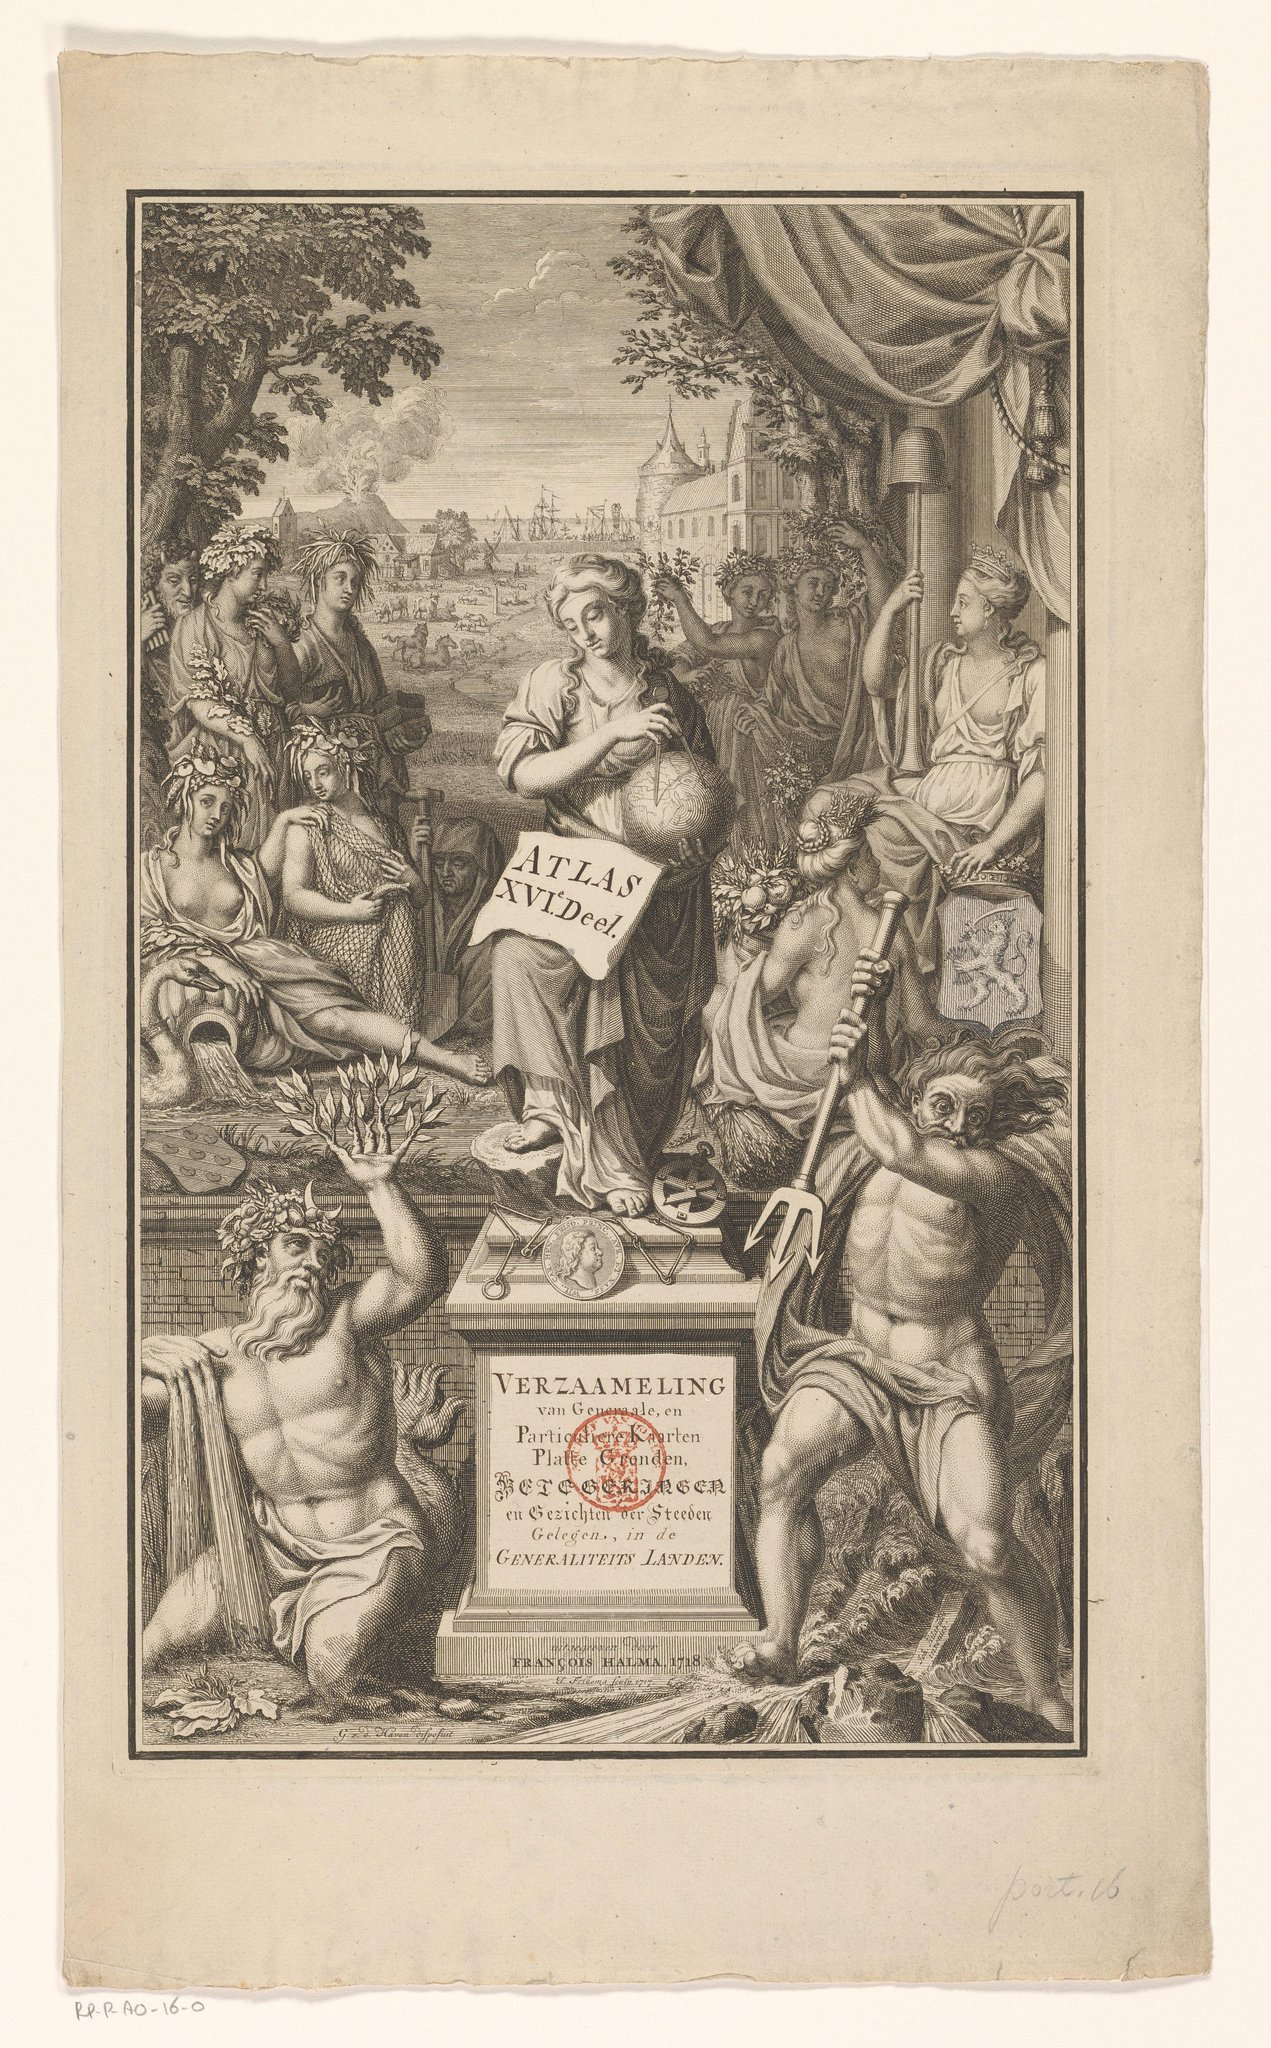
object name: titelprent, frontispice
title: Titelprent voor portefeuille 16 van de Atlas Ottens (Generaliteitslanden)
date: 1717-1718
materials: ink, paper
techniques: engraving, etching, pen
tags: commercial fishery, (story of) ceres (demeter), peat-cutting, 'astronomia', 'cosmografia'; 'cosmografia' (ripa), personifications of countries, nations, states, districts, etc., river-gods, 'corografia', 'geografia', 'hidrografia' (ripa), agriculture, fruitfulness, productiveness, fertility, fecundity; 'fecondità' (ripa), (story of) flora, coat of arms (as symbol of the state, etc.) (+ province; provincial), neptune as lord of the sea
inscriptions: collector's mark: Lugt 19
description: Deze prent is hier gebruikt als titelprent van een deel van een ongebonden atlas; een verzameling cartografische en topografische prenten en tekeningen. Oorspronkelijk was de prent echter bedoeld als titelpagina voor een gebonden atlas met kaarten van Friesland, waardoor een deel van de hier volgende beschrijving betrekking heeft op die context. Op het voetstuk in het midden staat de personificatie van de cartografie, met in haar hand een aardbol die ze met een passer meet. Op haar bovenbeen rust een blad met het handgeschreven deel van de atlas (oorspronkelijk een kaart van Friesland). Aan haar voeten een meetketting, een rond (land)meetkundig instrument en een portret van Willem IV van Oranje-Nassau. Daaronder de handgeschreven titel van dit deel van de atlas. Ze houdt een wakend oog op Wispelturigheid (Wispeltuer), linksonder. Oorspronkelijk staat hij voor de wispelturigheid waar het Friese land zich naar moest schikken: een bos kon opeens onder water staan, want zijn lichaam smelt door het zoute water van de zee. Linksboven zijn hoofd een wapenschild met het wapen van Friesland (met schuinbalken en pompeblêden). De dreiging van de zee is rechtsonder verbeeld door een onstuimige Neptunus (Zeevoogd). Links en rechts van Cartografie nog meer figuren die oorspronkelijk betrekking hadden op Friesland en haar vruchtbare natuur, visserij en landbouw. Links, met haar arm leunend op een kruik waar water uitstroomt, een stroomgodin (Stroomvoogdess) met rechts van haar de personificatie van de visserij (Visschevang). Boven hen van links naar rechts: een sater met fluit als personificatie van de natuur (Natuer), de personificatie van de bossen met eikenloven (Woudman) en personificatie van de turfwinning (vrouw Veenbrand). Rechtsonder haar vrouw Onland, die rouwt om de schade die de turfwinning aan het land veroorzaakt. Rechts van Cartografie zit Flora en/of Ceres (vrouw Veldgewas) met korenaren en cornucopia, ze staat voor de overvloed die voortvloeit uit het land. Boven haar, op de achtergrond, twee vrouwelijke personificaties die in verband staan met groene weides en/of grasvelden: Beemdeheil en Graazevol. Rechts, met in haar ene hand een bazuin met daarop een vrijheidshoed en in de andere hand een wapenschild met de Generaliteitsleeuw, de personificatie van het gebied van dit deel van de atlas (oorspronkelijk de Friese Maagd met het provinciewapen met twee leeuwen). Op de achtergrond een landschap met kenmerkende Friese elementen, zoals het Sjaerdemaslot te Franeker en de vuurspuwende Rode Klif te Gaasterland (zou in de oudheid een vulkaan zijn geweest).